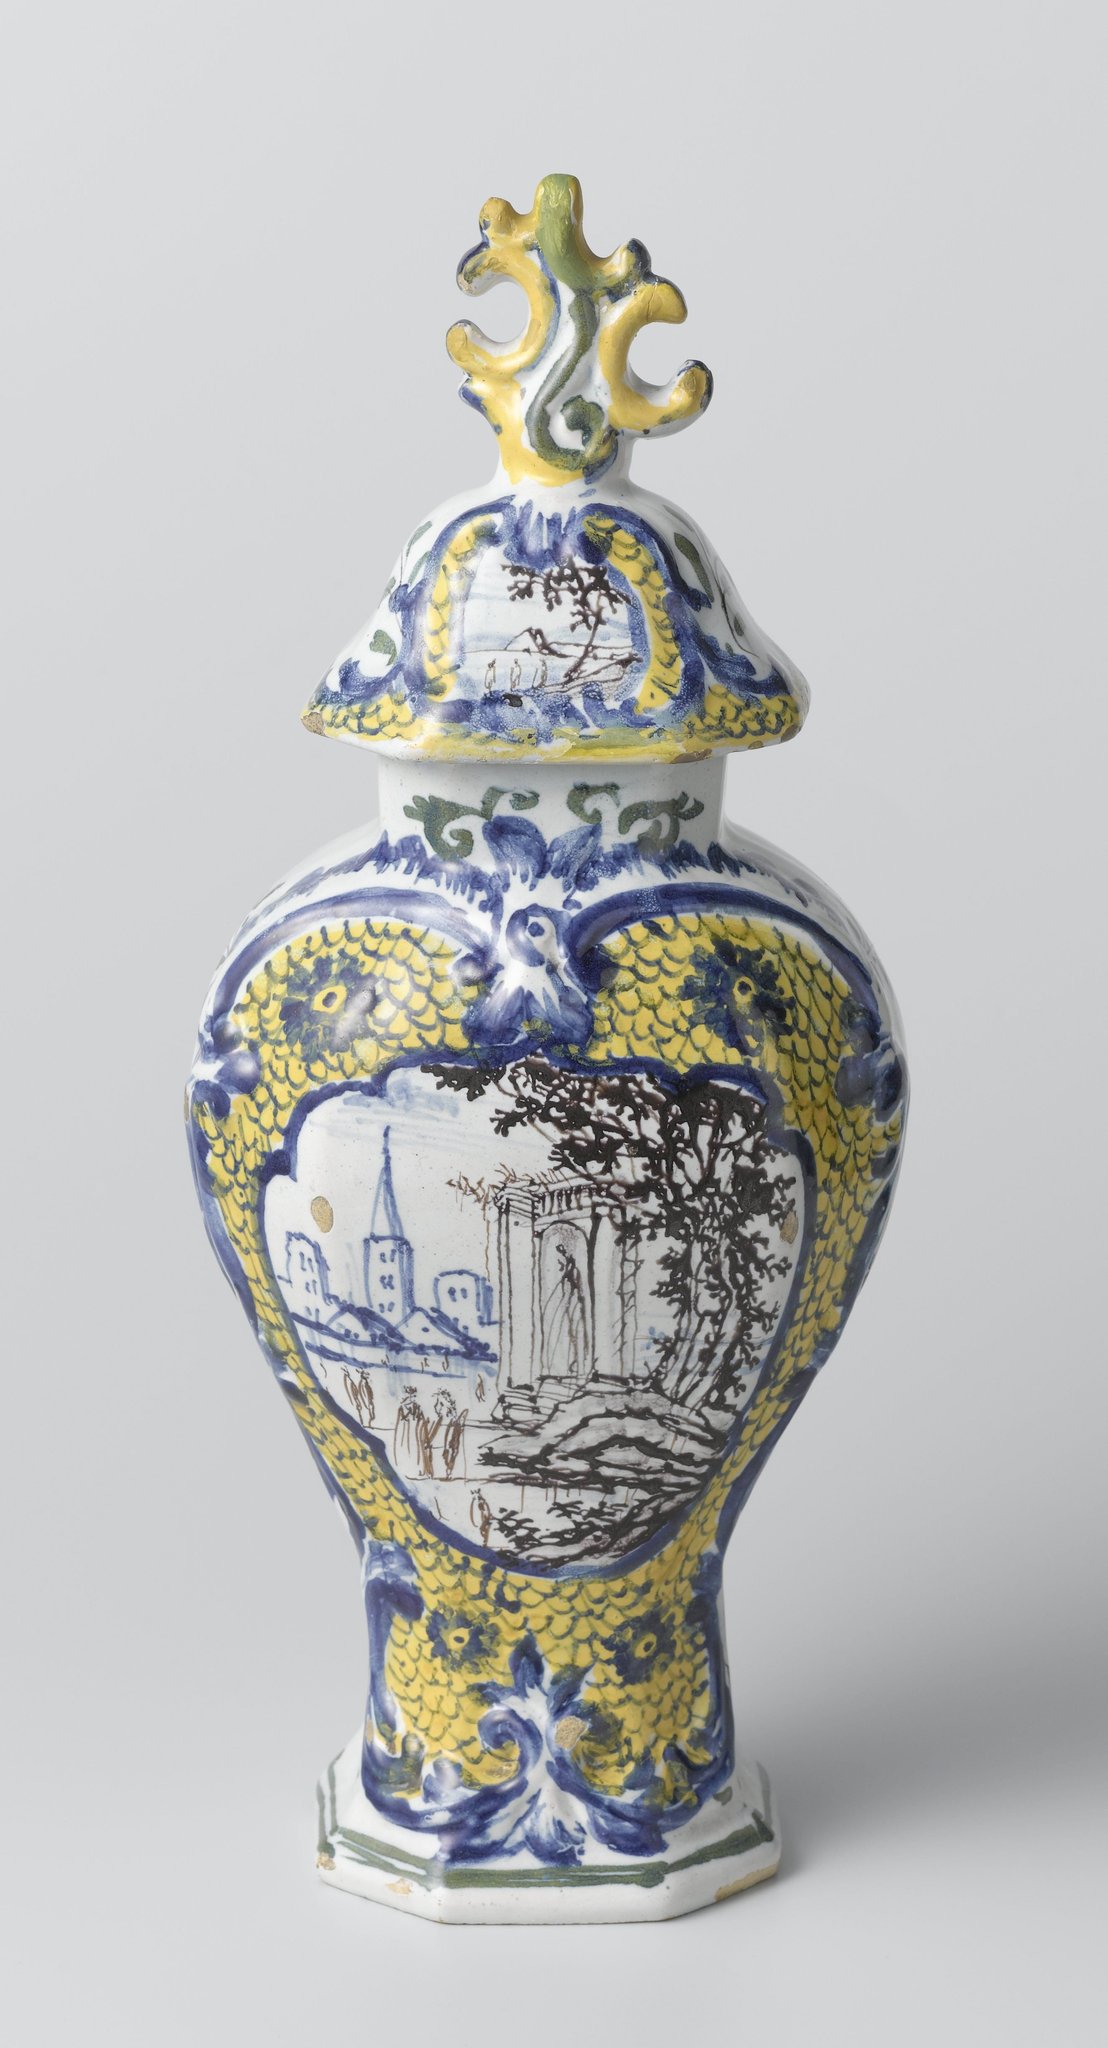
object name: covered jar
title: Pot met deksel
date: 1780-1820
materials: faience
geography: delft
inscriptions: mark: ‘B:P’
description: Pot met deksel van faience. Veelkleurig beschilderd. De pot is gemerkt: B-P.